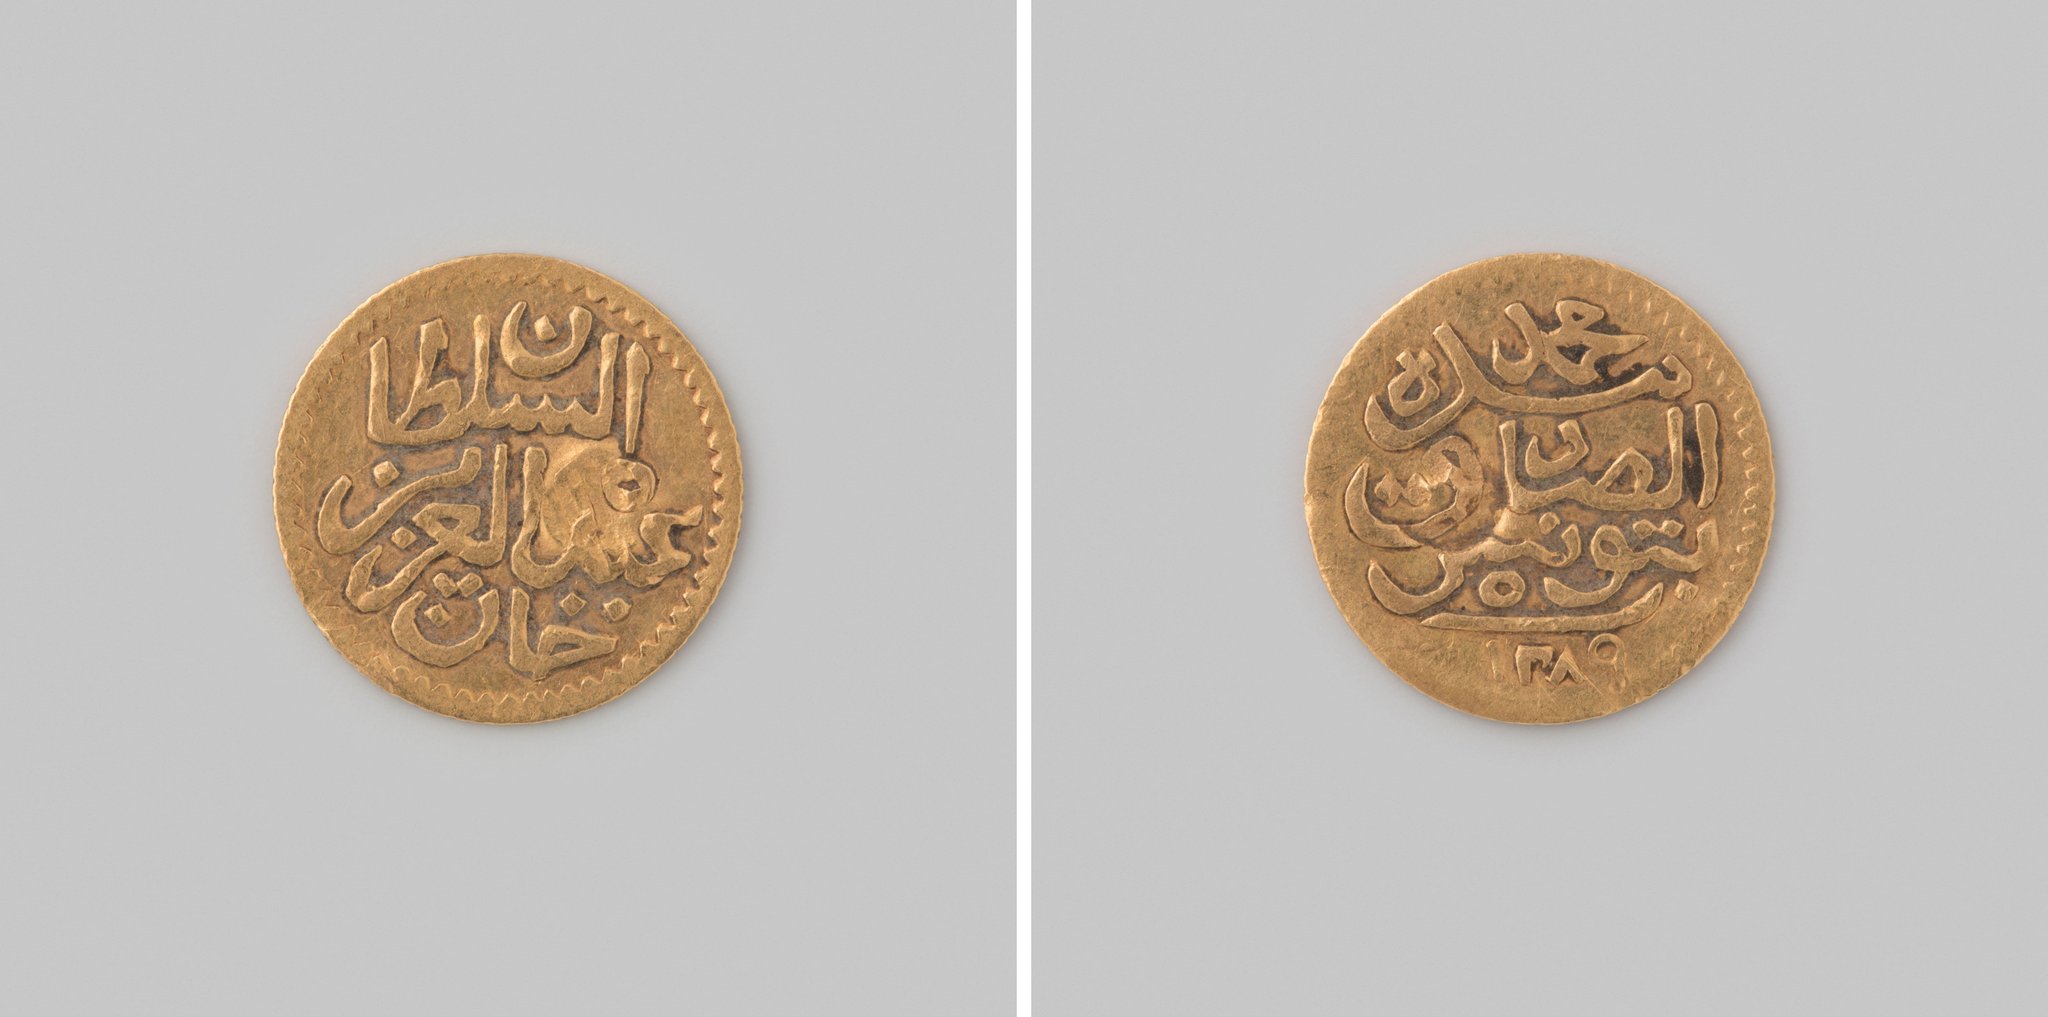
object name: vijfentwintig kuru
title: 25 kurush of 1/4 pond uit Turkije van sultan Abdul Aziz, regeringsjaar 3 [=1863]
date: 1863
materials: gold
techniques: striking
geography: constantinople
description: Gouden munt. Voorzijde: tussen twee gekruiste houders, waaruit takken tughra, Boven tughra ring van sterren. Onder tughra regeringsjaar-aanduiding: 3. Keerzijde: binnen twee samengebonden takken drieregelig opschrift met muntplaats-aanduiding: Constantinopel, waaronder aanduiding jaar van aantreden: 1277 [=1861].